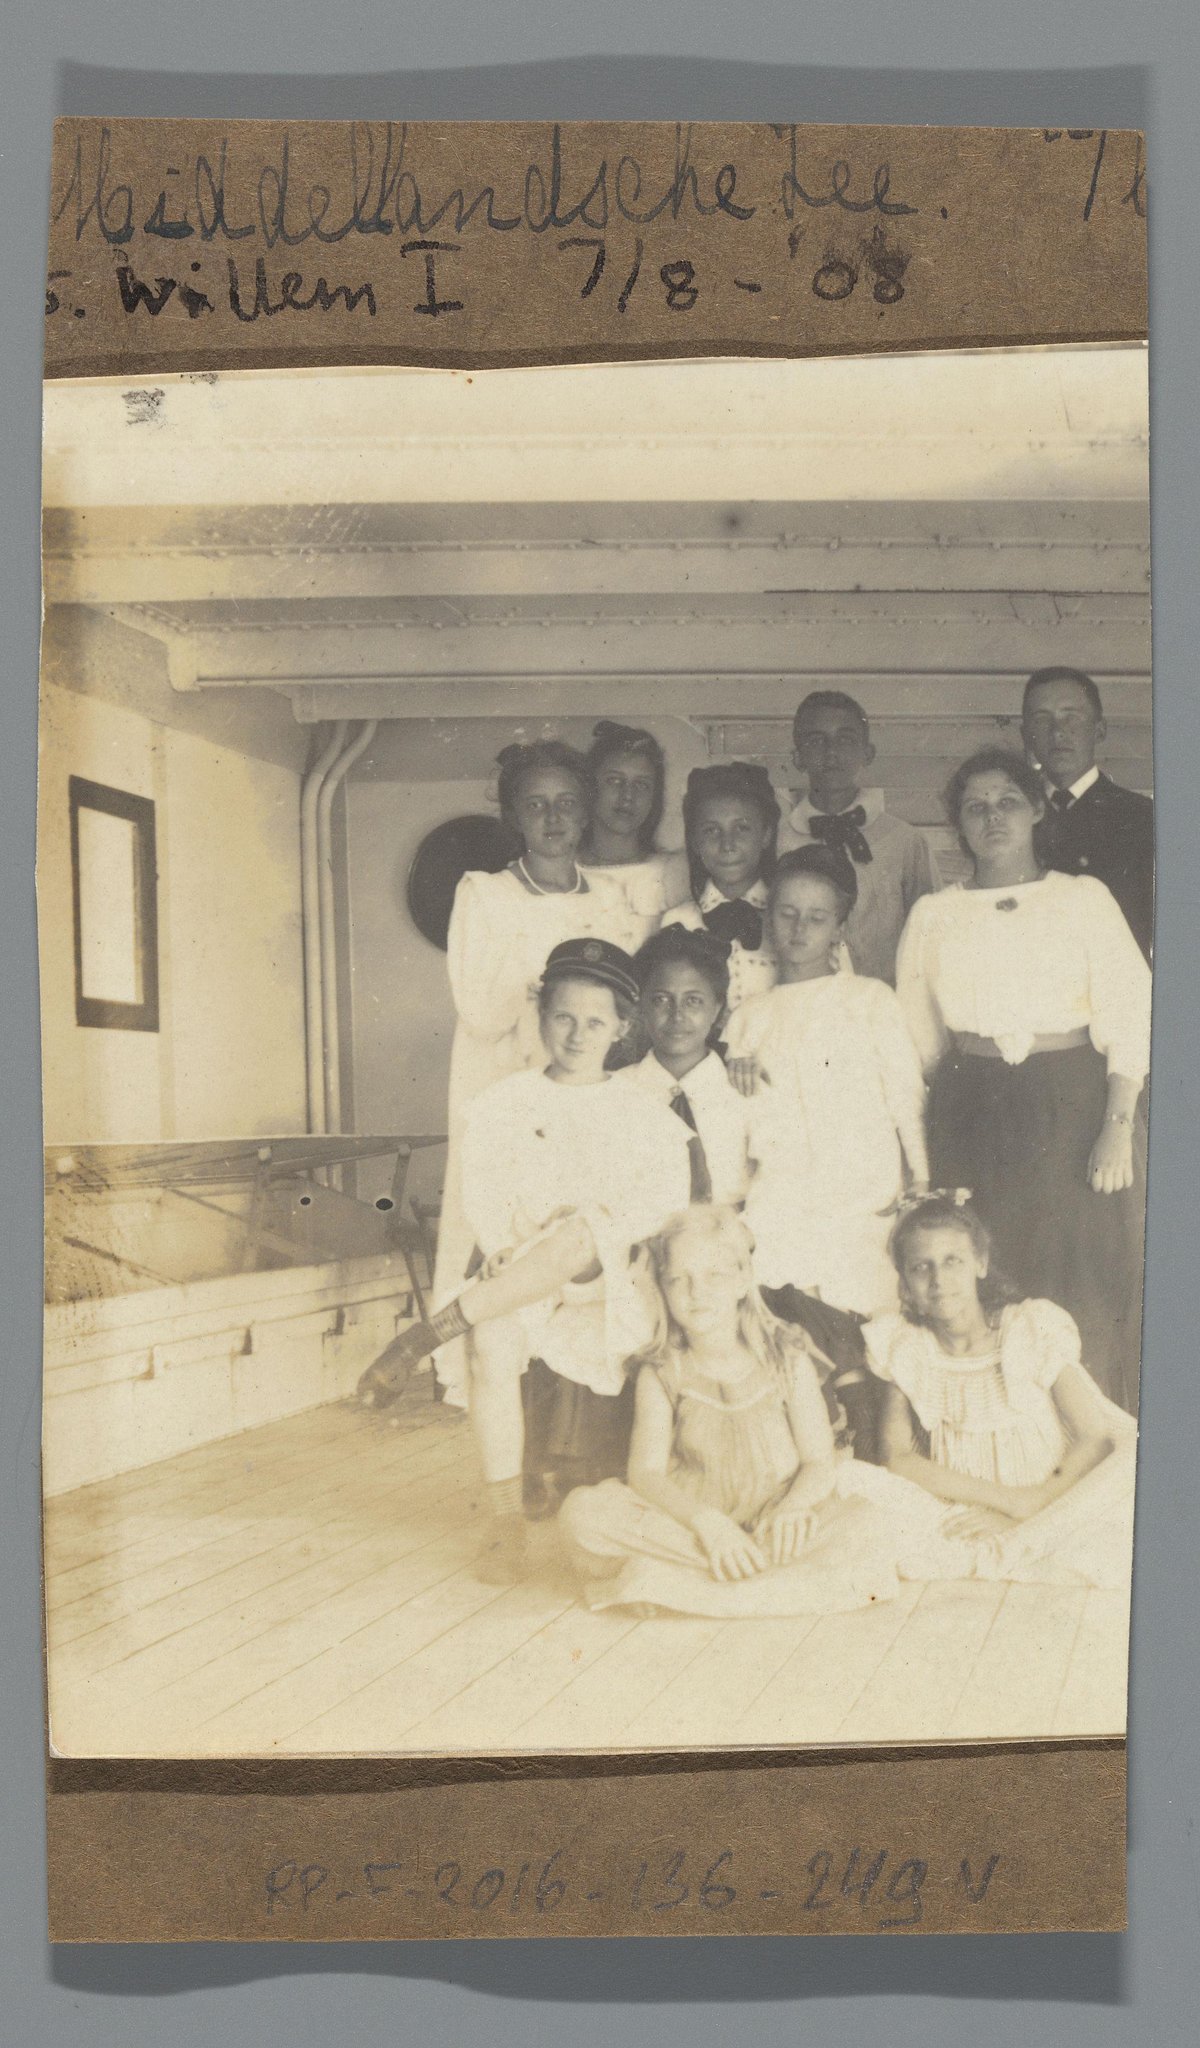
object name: photograph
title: Groepsportret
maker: Anonymous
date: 1908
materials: cardboard, photographic support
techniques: albumen print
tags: batavia, emilie albertine onnen-van den berg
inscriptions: inscription: ‘Middellandsche Zee / Willem I 7/8 - '08’